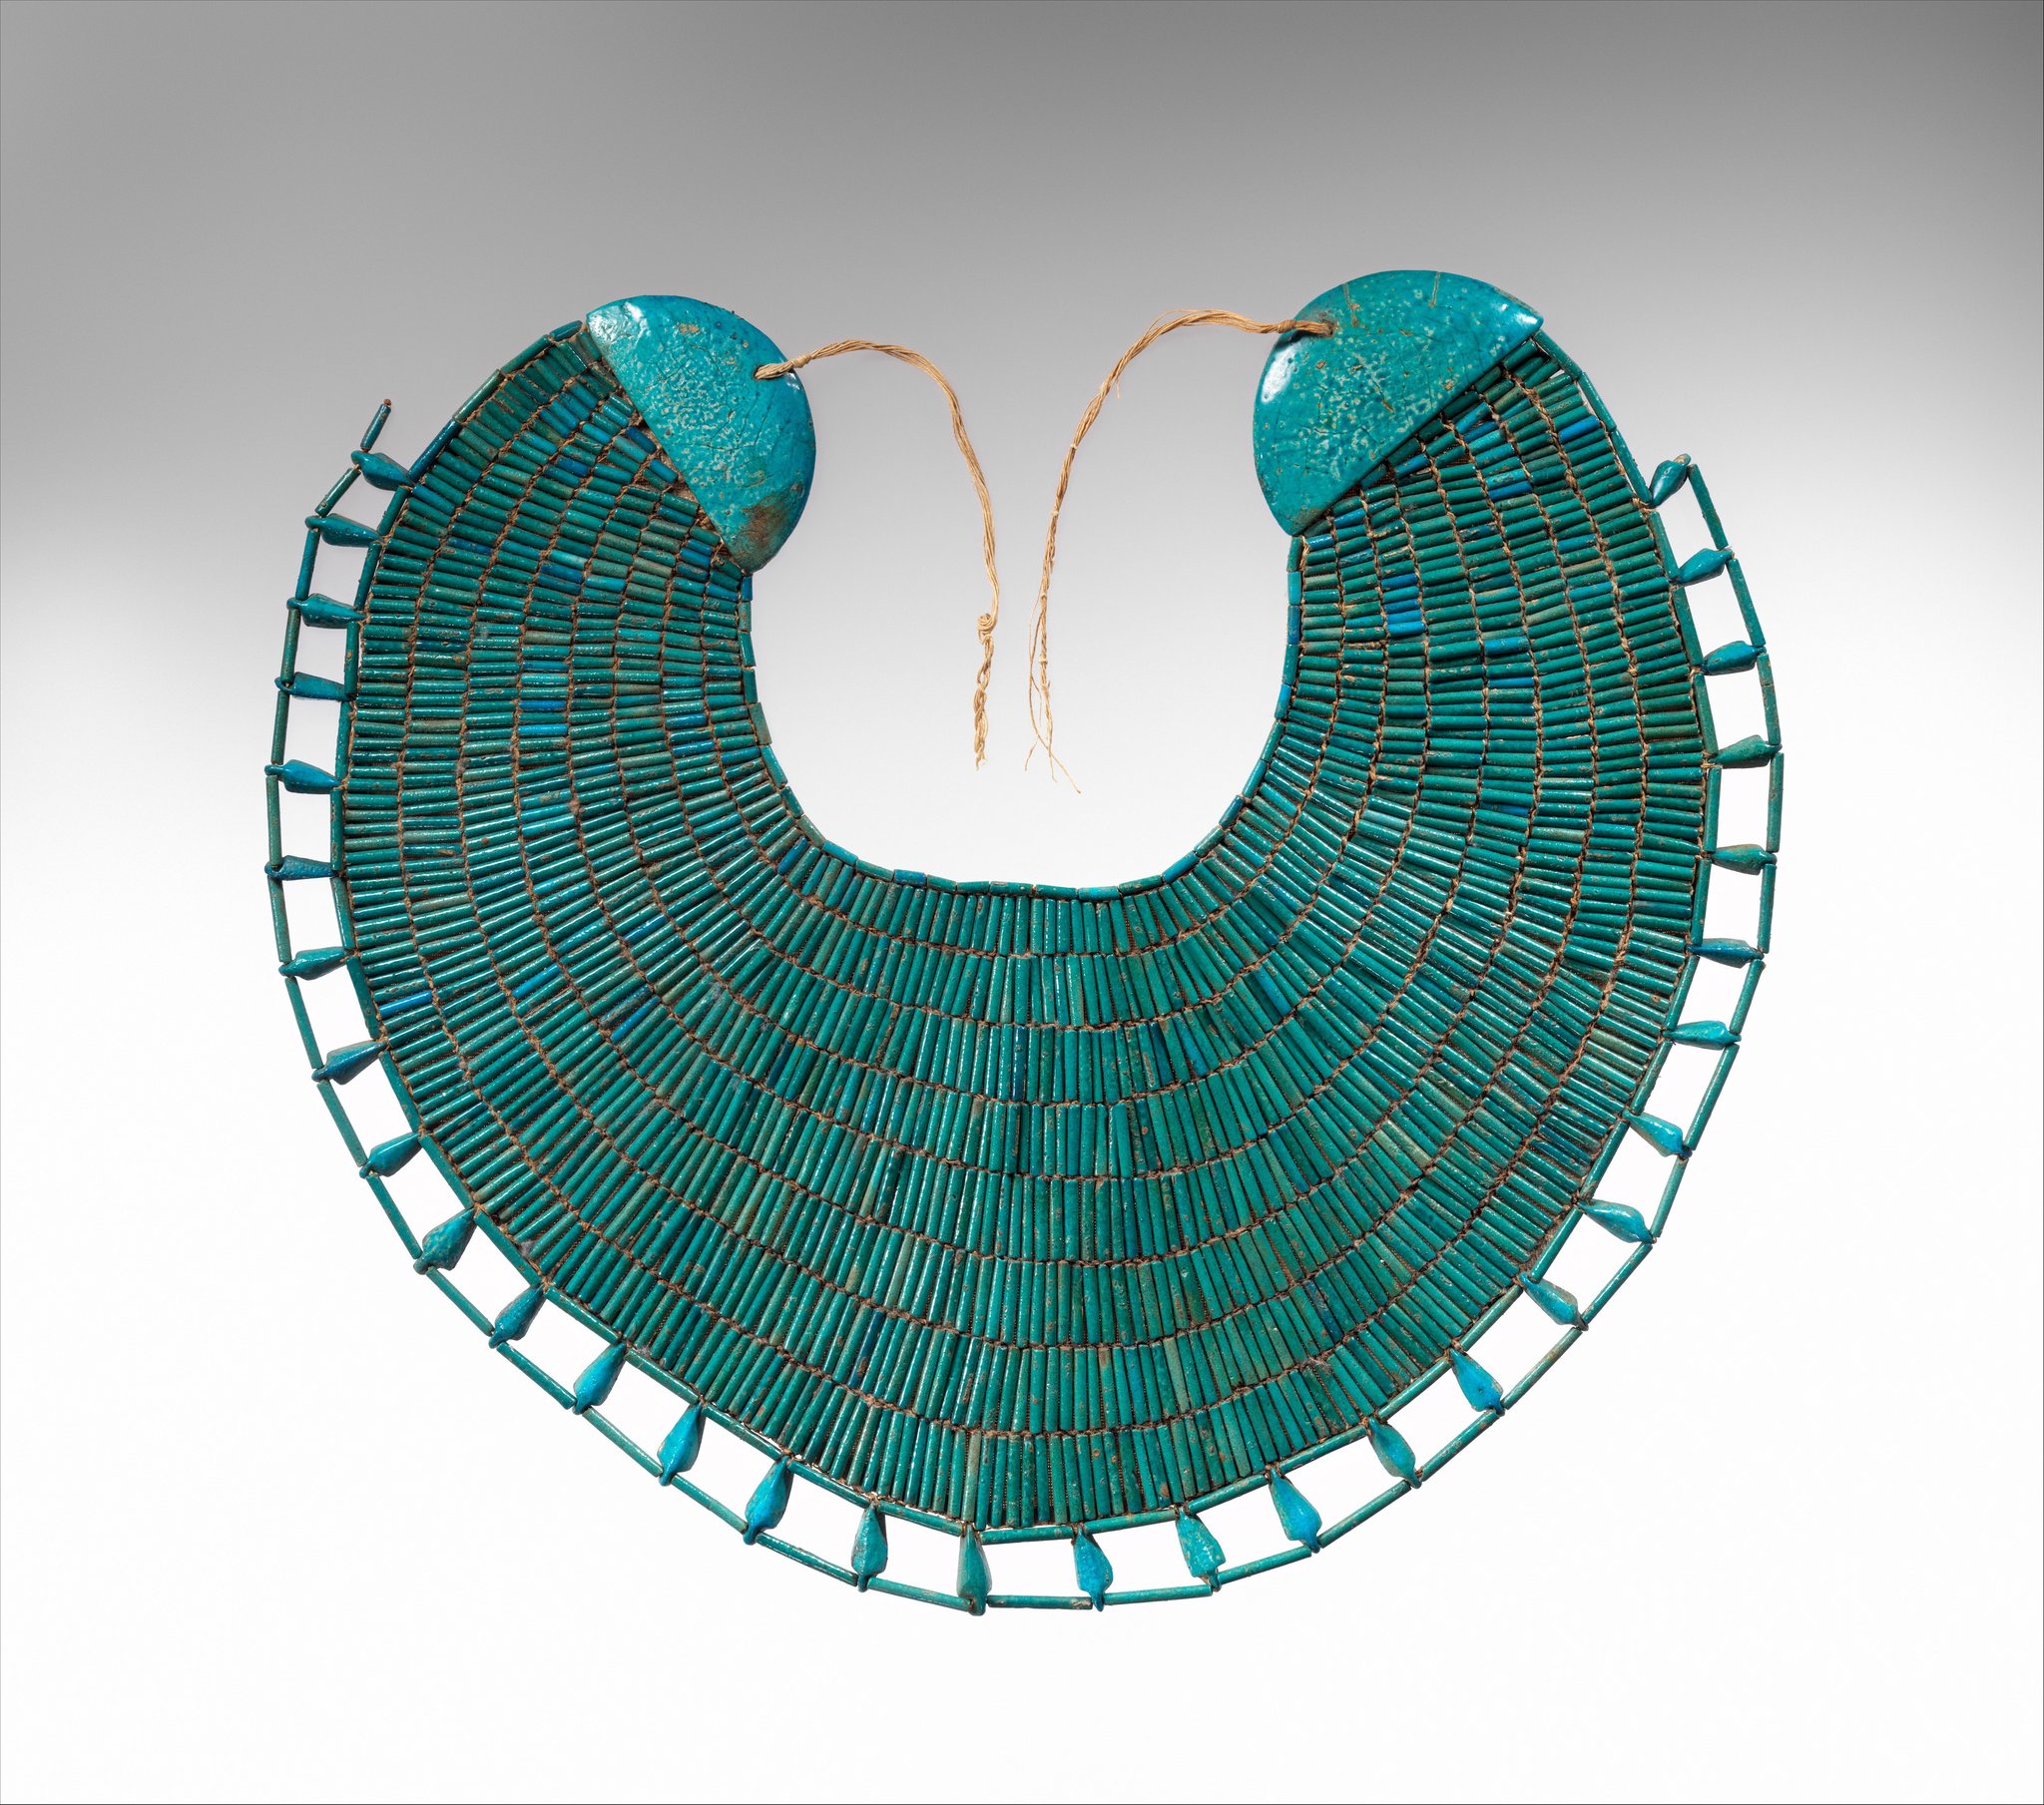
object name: broad collar, wah, bead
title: Broad Collar of Wah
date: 1981-1975 BCE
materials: faience, linen, thread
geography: egypt